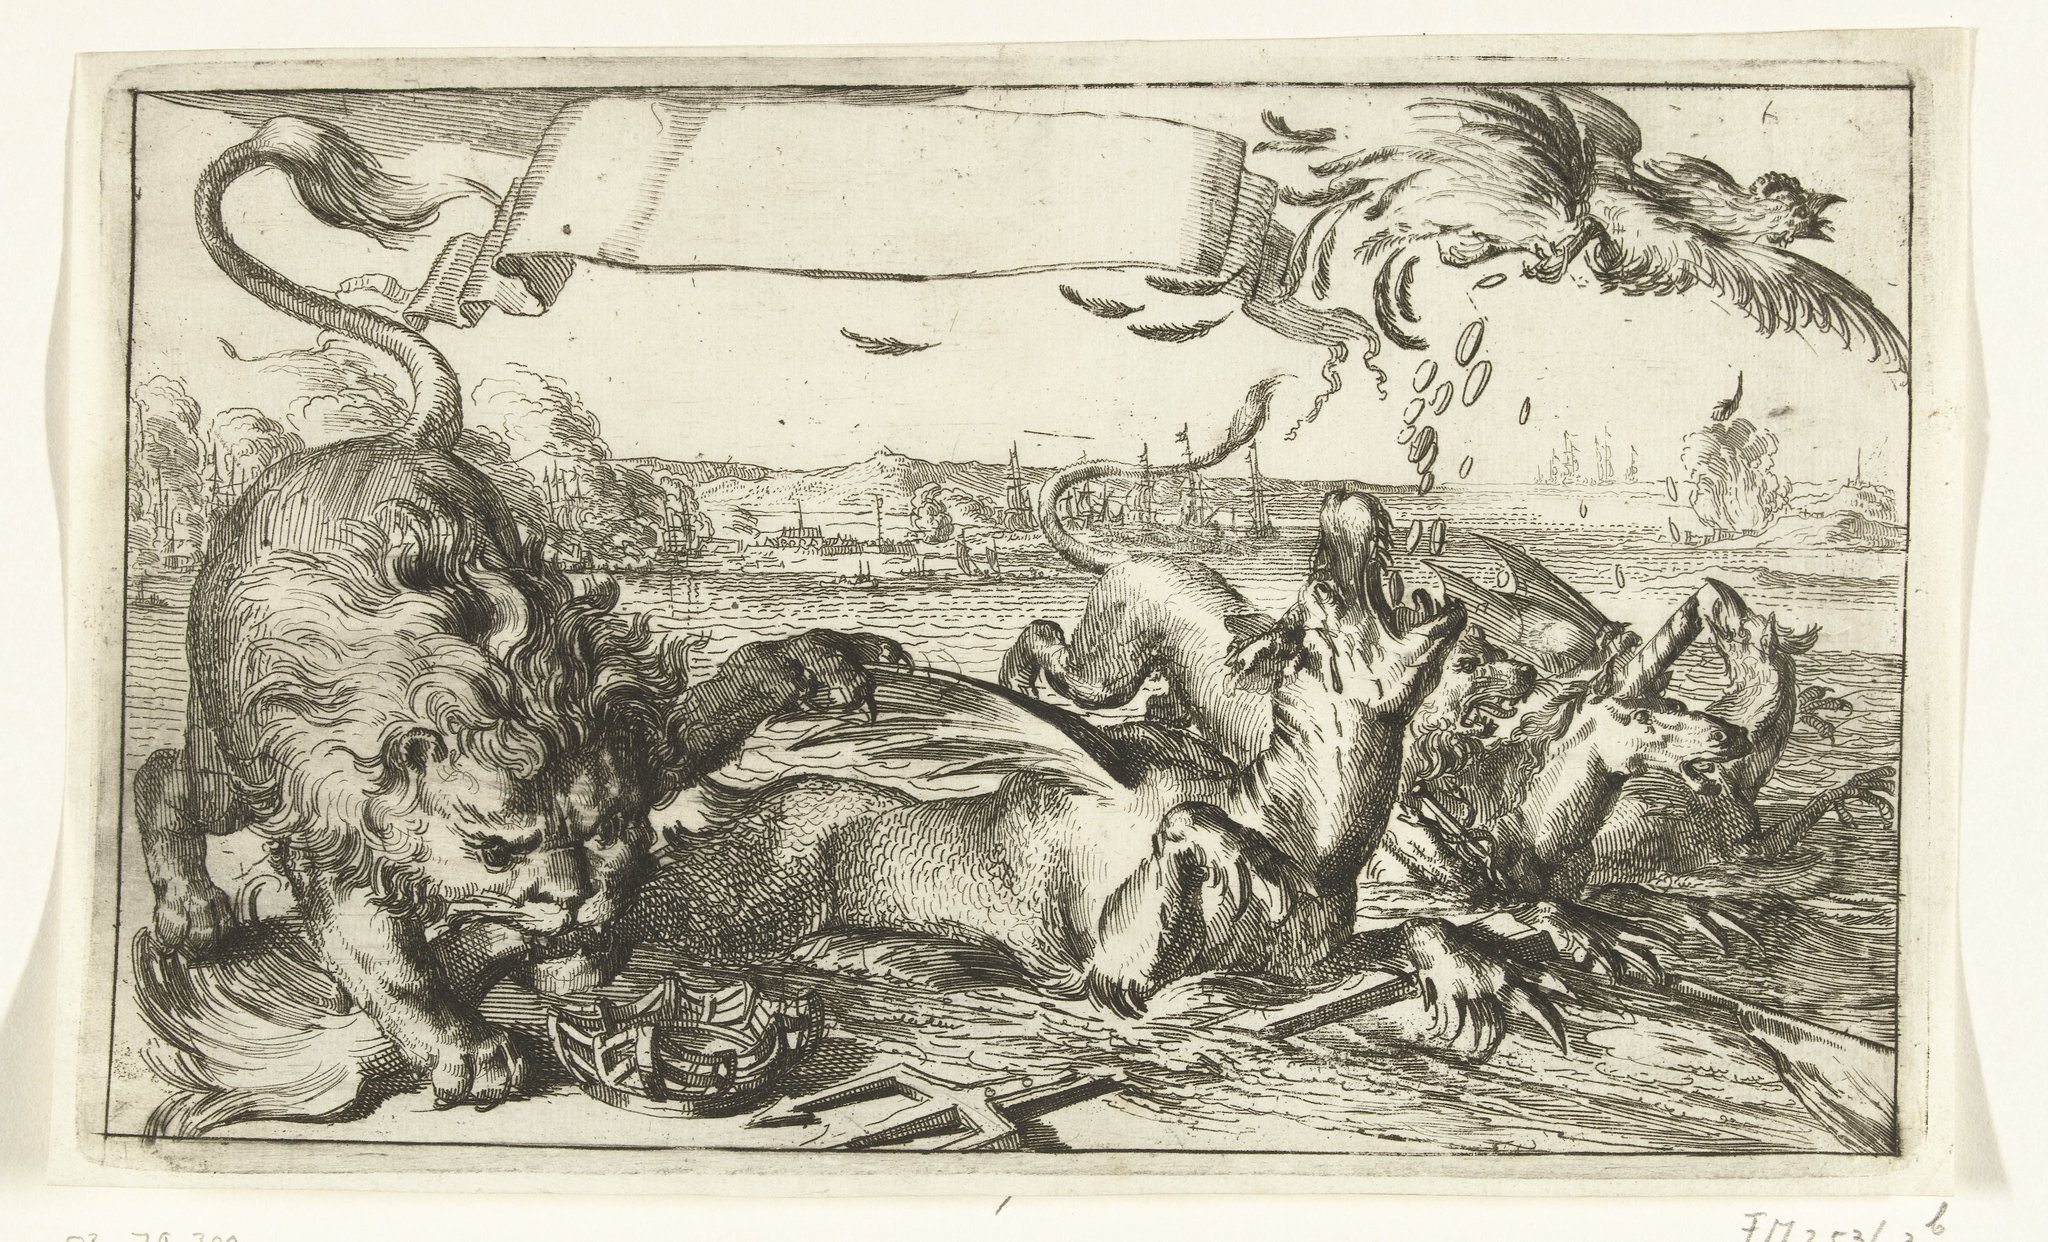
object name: print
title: Gezamenlijke heerschappij van Nederland en Engeland over de zeeën, 1674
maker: romeyn de hooghe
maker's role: draughtsman, goldsmith, painter, print maker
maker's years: 1645-1708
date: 1674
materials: paper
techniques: etching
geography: northern netherlands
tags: political caricatures and satires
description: Gezamenlijke heerschappij van Nederland en Engeland over de zeeën, 1674. Een griffioen (Ierland), eenhoorn (Schotland), leeuw (Republiek) en draak (Engeland) beheersen gezamelijk de zeeën, in de lucht vlucht een haan, veren en munten achter zich latend. Op de voorgrond een leeuw bij een schepenkroon en een slang om het woord Vrede. Bovenaan een leeg cartouche.